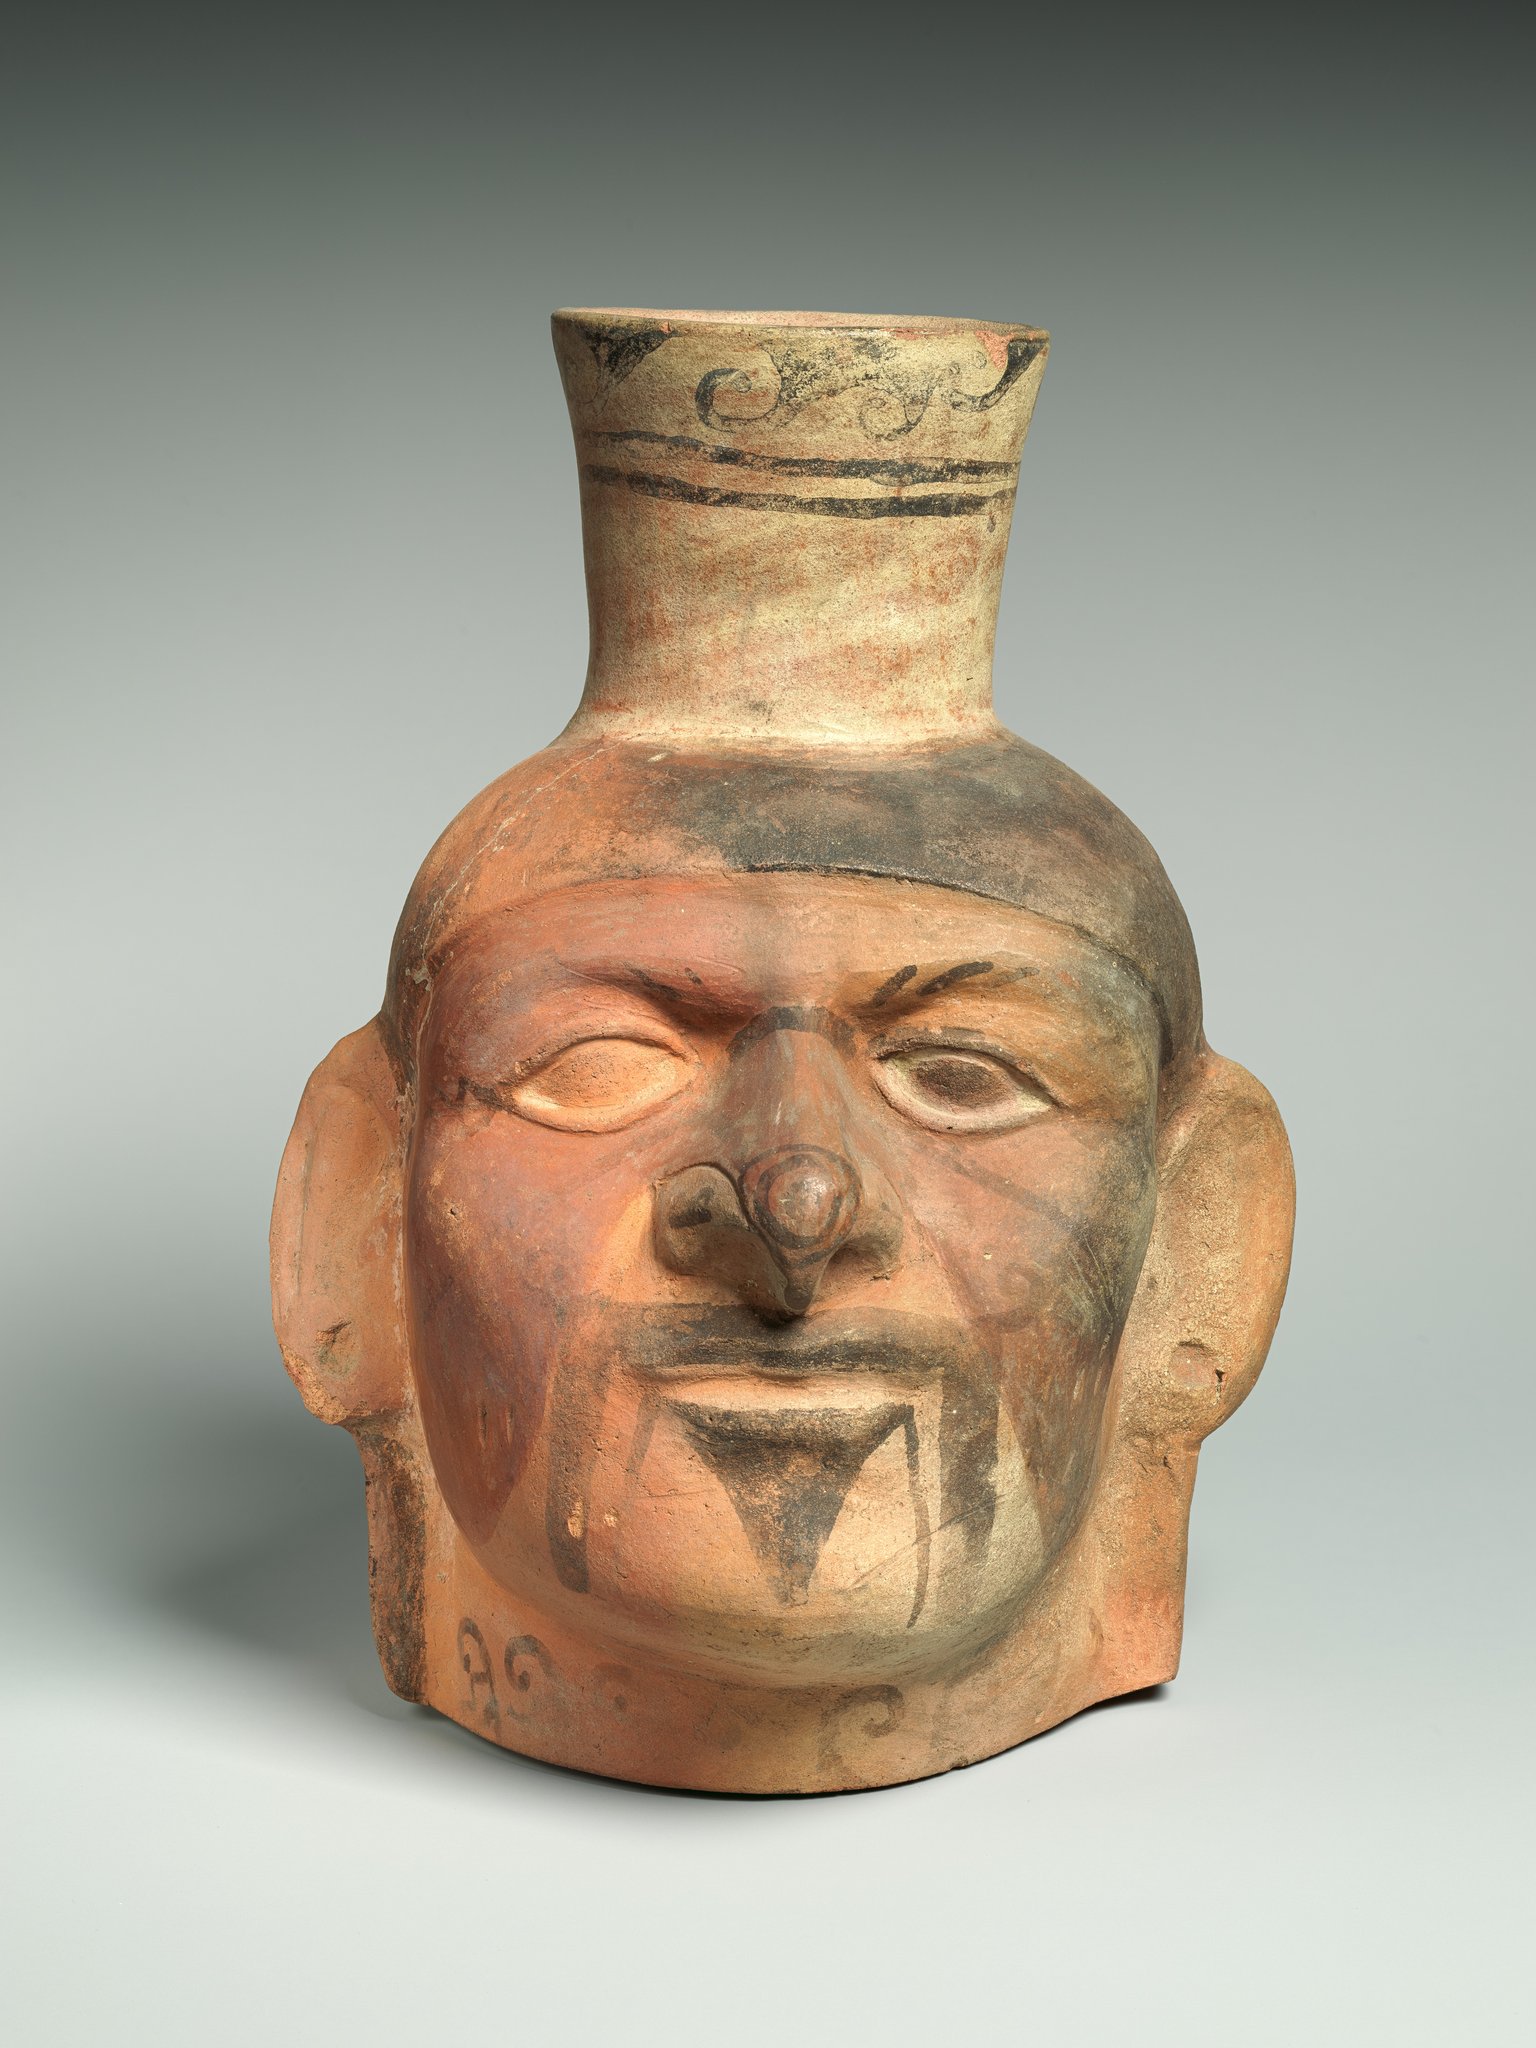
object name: bottle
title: Single Spout Portrait Head Bottle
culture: moche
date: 201-600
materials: ceramic, pigment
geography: peru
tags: heads